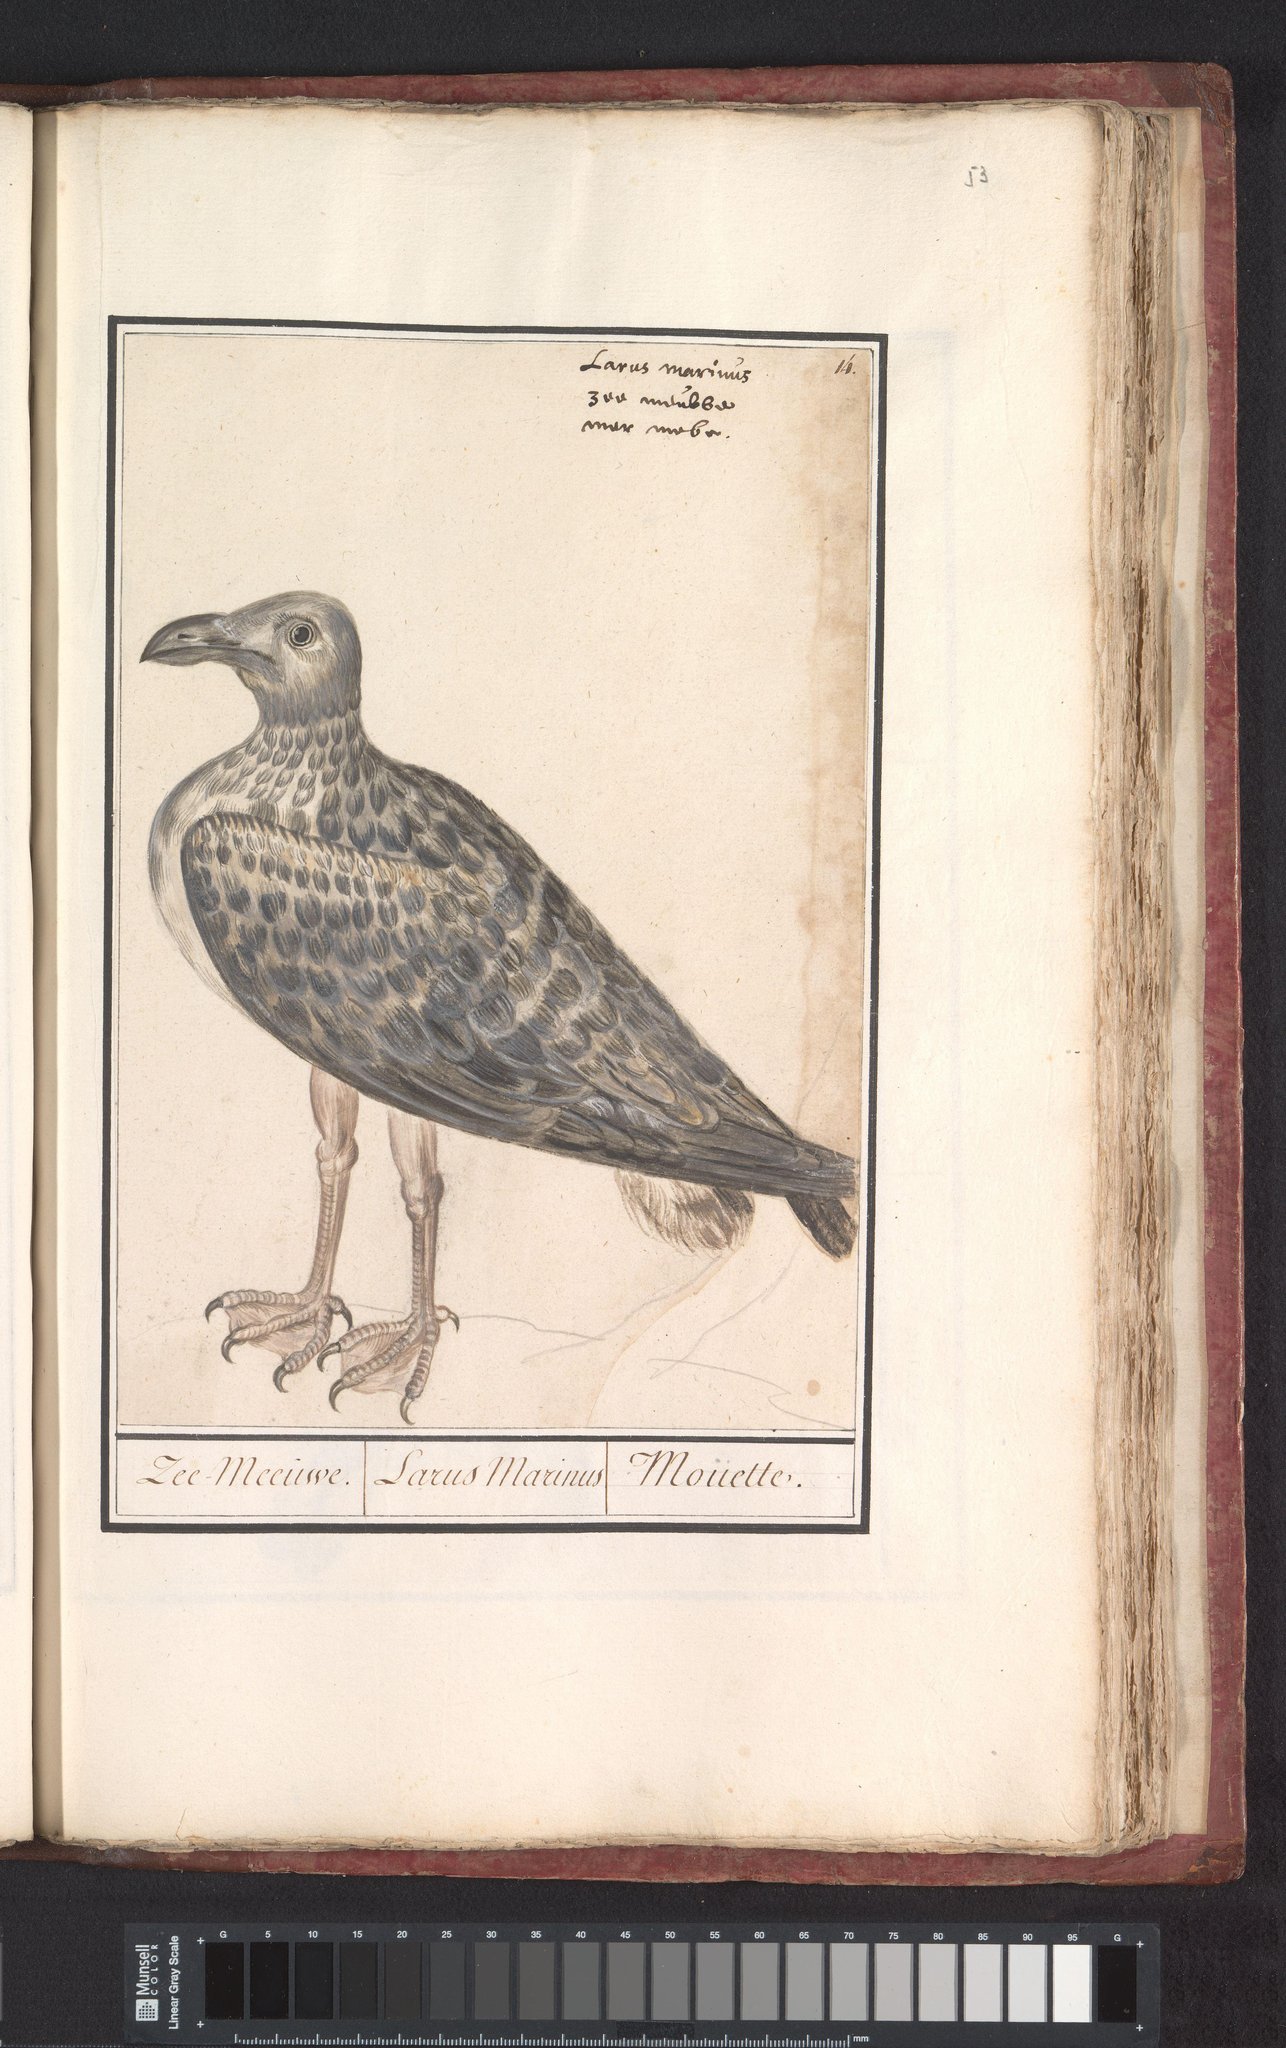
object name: drawing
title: Zee-Meeuwe. / Larus Marinus / Mouette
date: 1596-1610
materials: chalk, paint, ink, paper, pencil, watercolor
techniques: brush, pen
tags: shore-birds and wading-birds: gull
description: Grote mantelmeeuw of zilvermeeuw (juveniel). Genummerd rechtsboven: 14. Rechtsboven de naam in drie talen. Onderdeel van het derde album met tekeningen van vogels. Vijfde van twaalf albums met tekeningen van dieren, vogels en planten bekend rond 1600, gemaakt in opdracht van keizer Rudolf II. Met toelichting in Nederlands, Latijn en Frans.